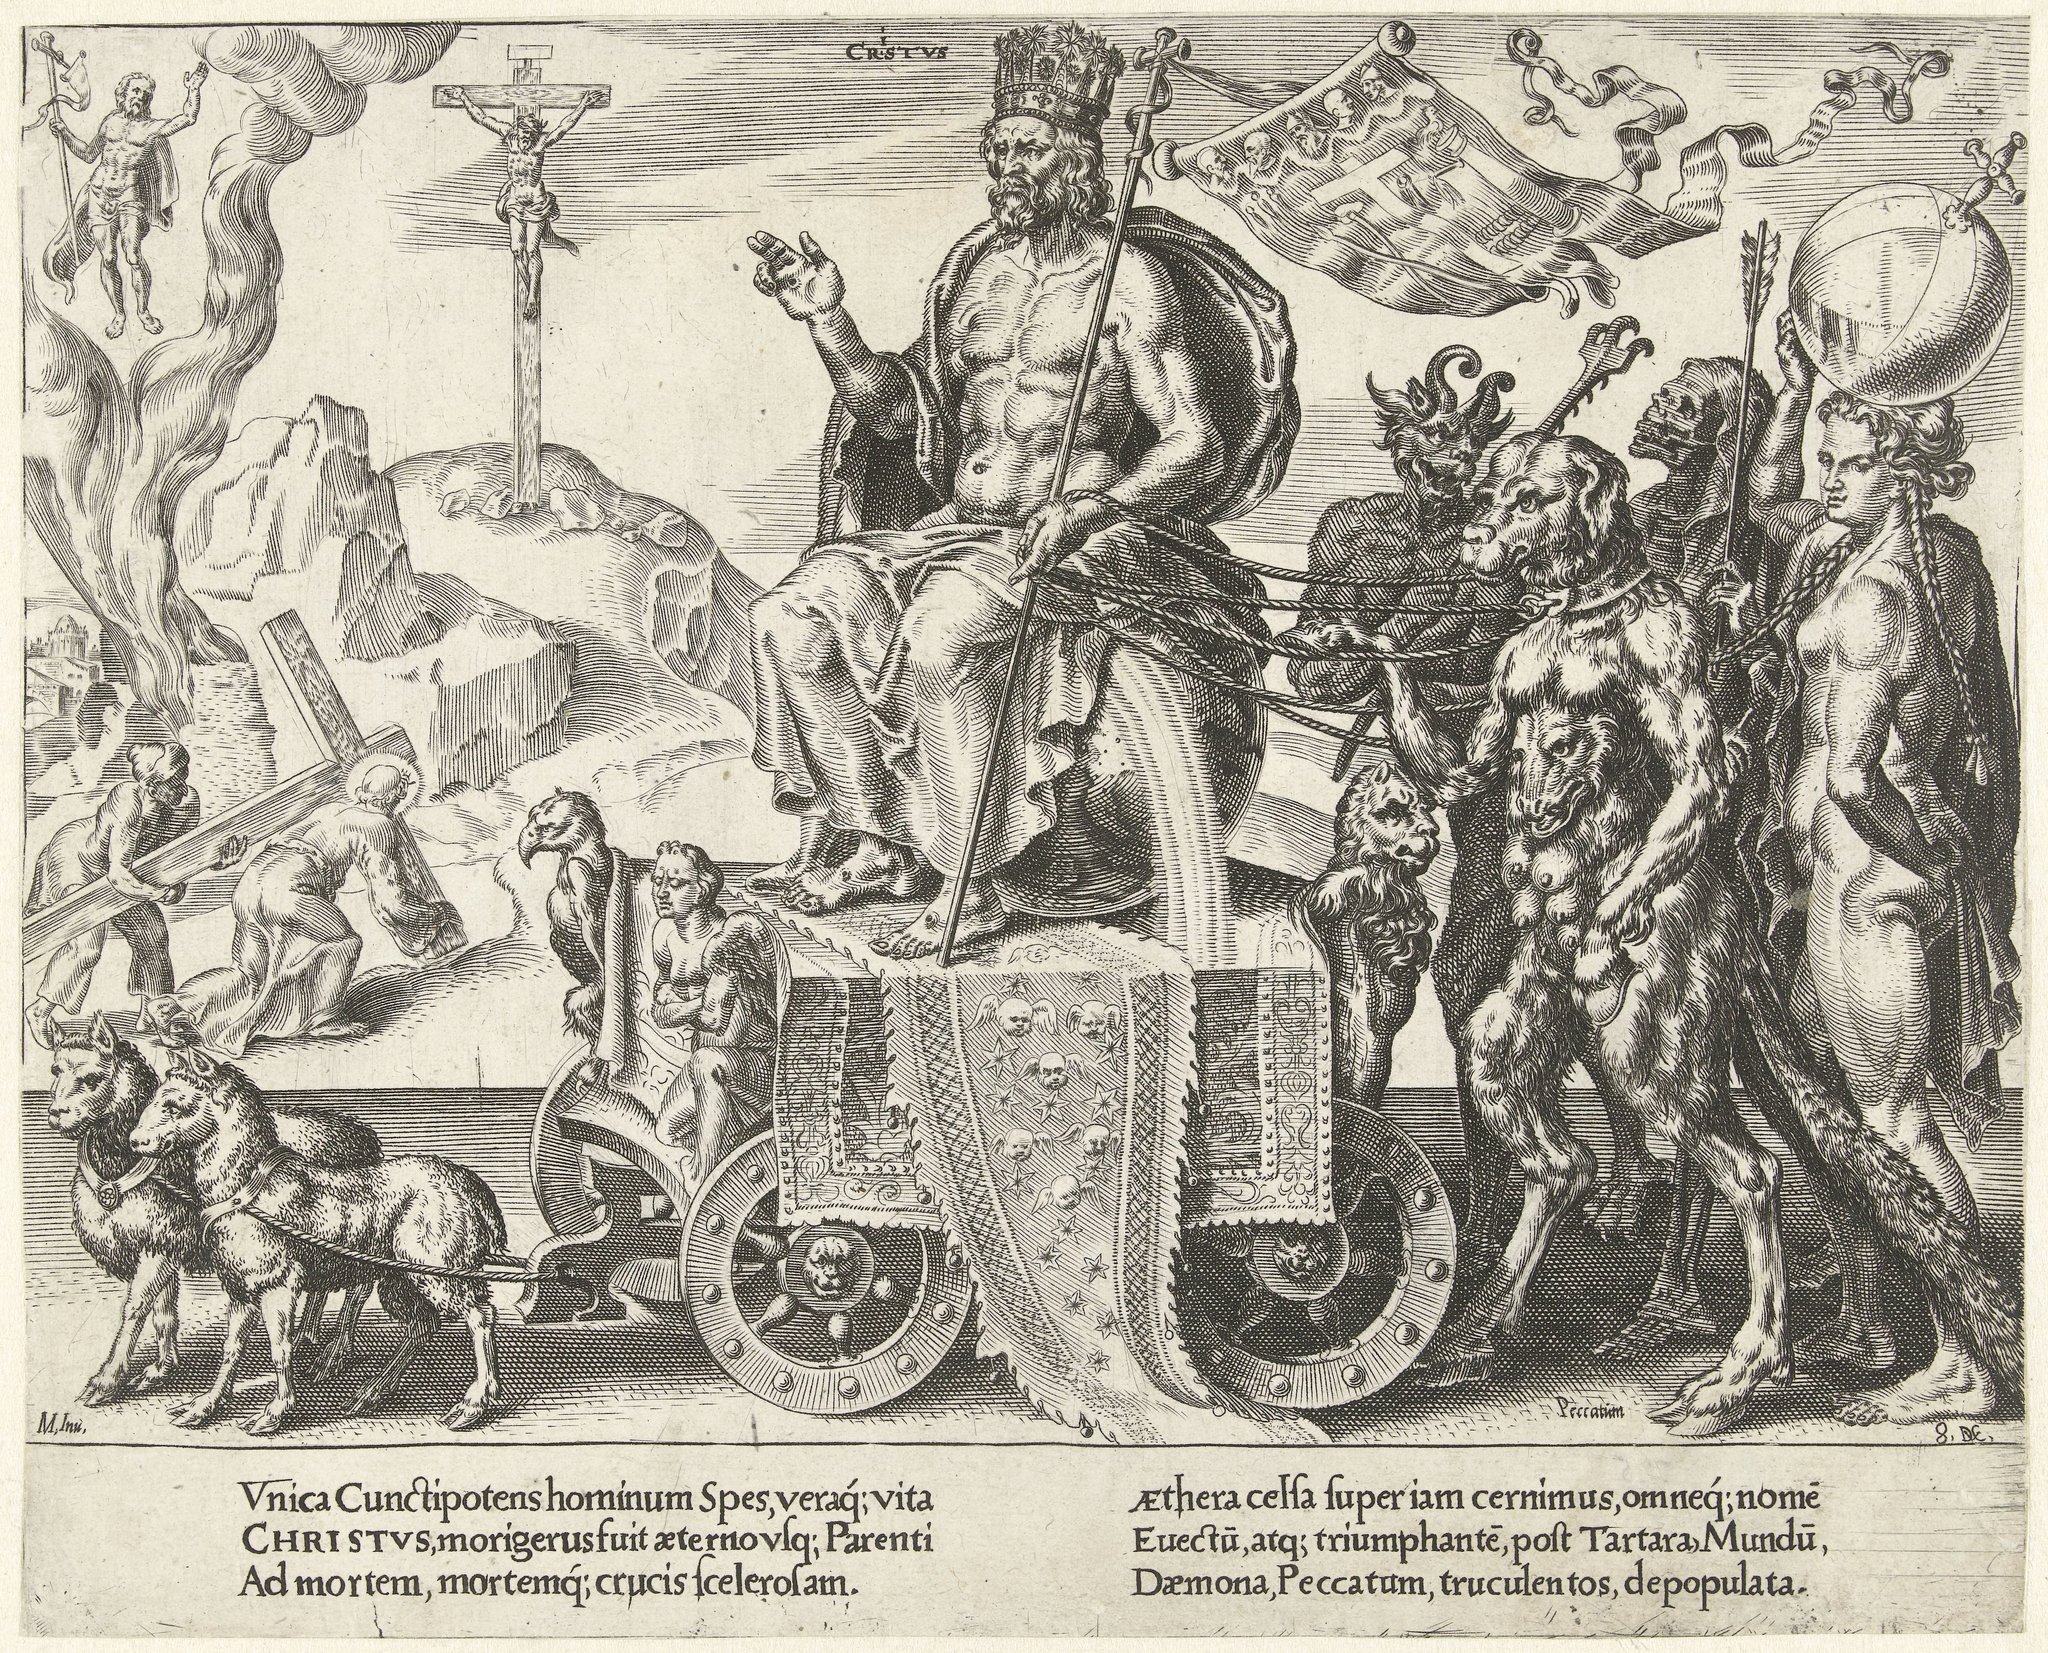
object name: print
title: Triomf van Christus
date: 1559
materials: paper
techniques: engraving, etching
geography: haarlem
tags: christ on the cross on golgotha (alone, without bystanders), resurrection of christ, death as man, the instruments of the passion and the five wounded limbs, devil(s) and demons: satan, vice, evil, sin; 'peccato' (ripa), triumphant christ, e.g. on triumphal chariot, 'mondo', 'machina del mondo' (ripa), carrying of the cross: christ bearing the cross, alone or with the help of others (e.g. simon the cyrenian)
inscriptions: collector's mark: Lugt 2228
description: Op de voorgrond Christus, rijdend op een triomfwagen getrokken door twee lammeren. Hij troont op de wereld. In zijn linkerhand een kruis met een vaandel. Op het vaandel de werktuigen van zijn passie. Achter de triomfwagen heeft Christus de Dood, Satan, Zonde (Peccatum) en Vrouwe Wereld geketend. Op de achtergrond worden Christus' kruisvaart, kruisdood en hemelvaart weergegeven. De prent heeft een Latijnse tekst van zes regels en maakt deel uit van een achtdelige serie over de triomf van de Lijdzaamheid.